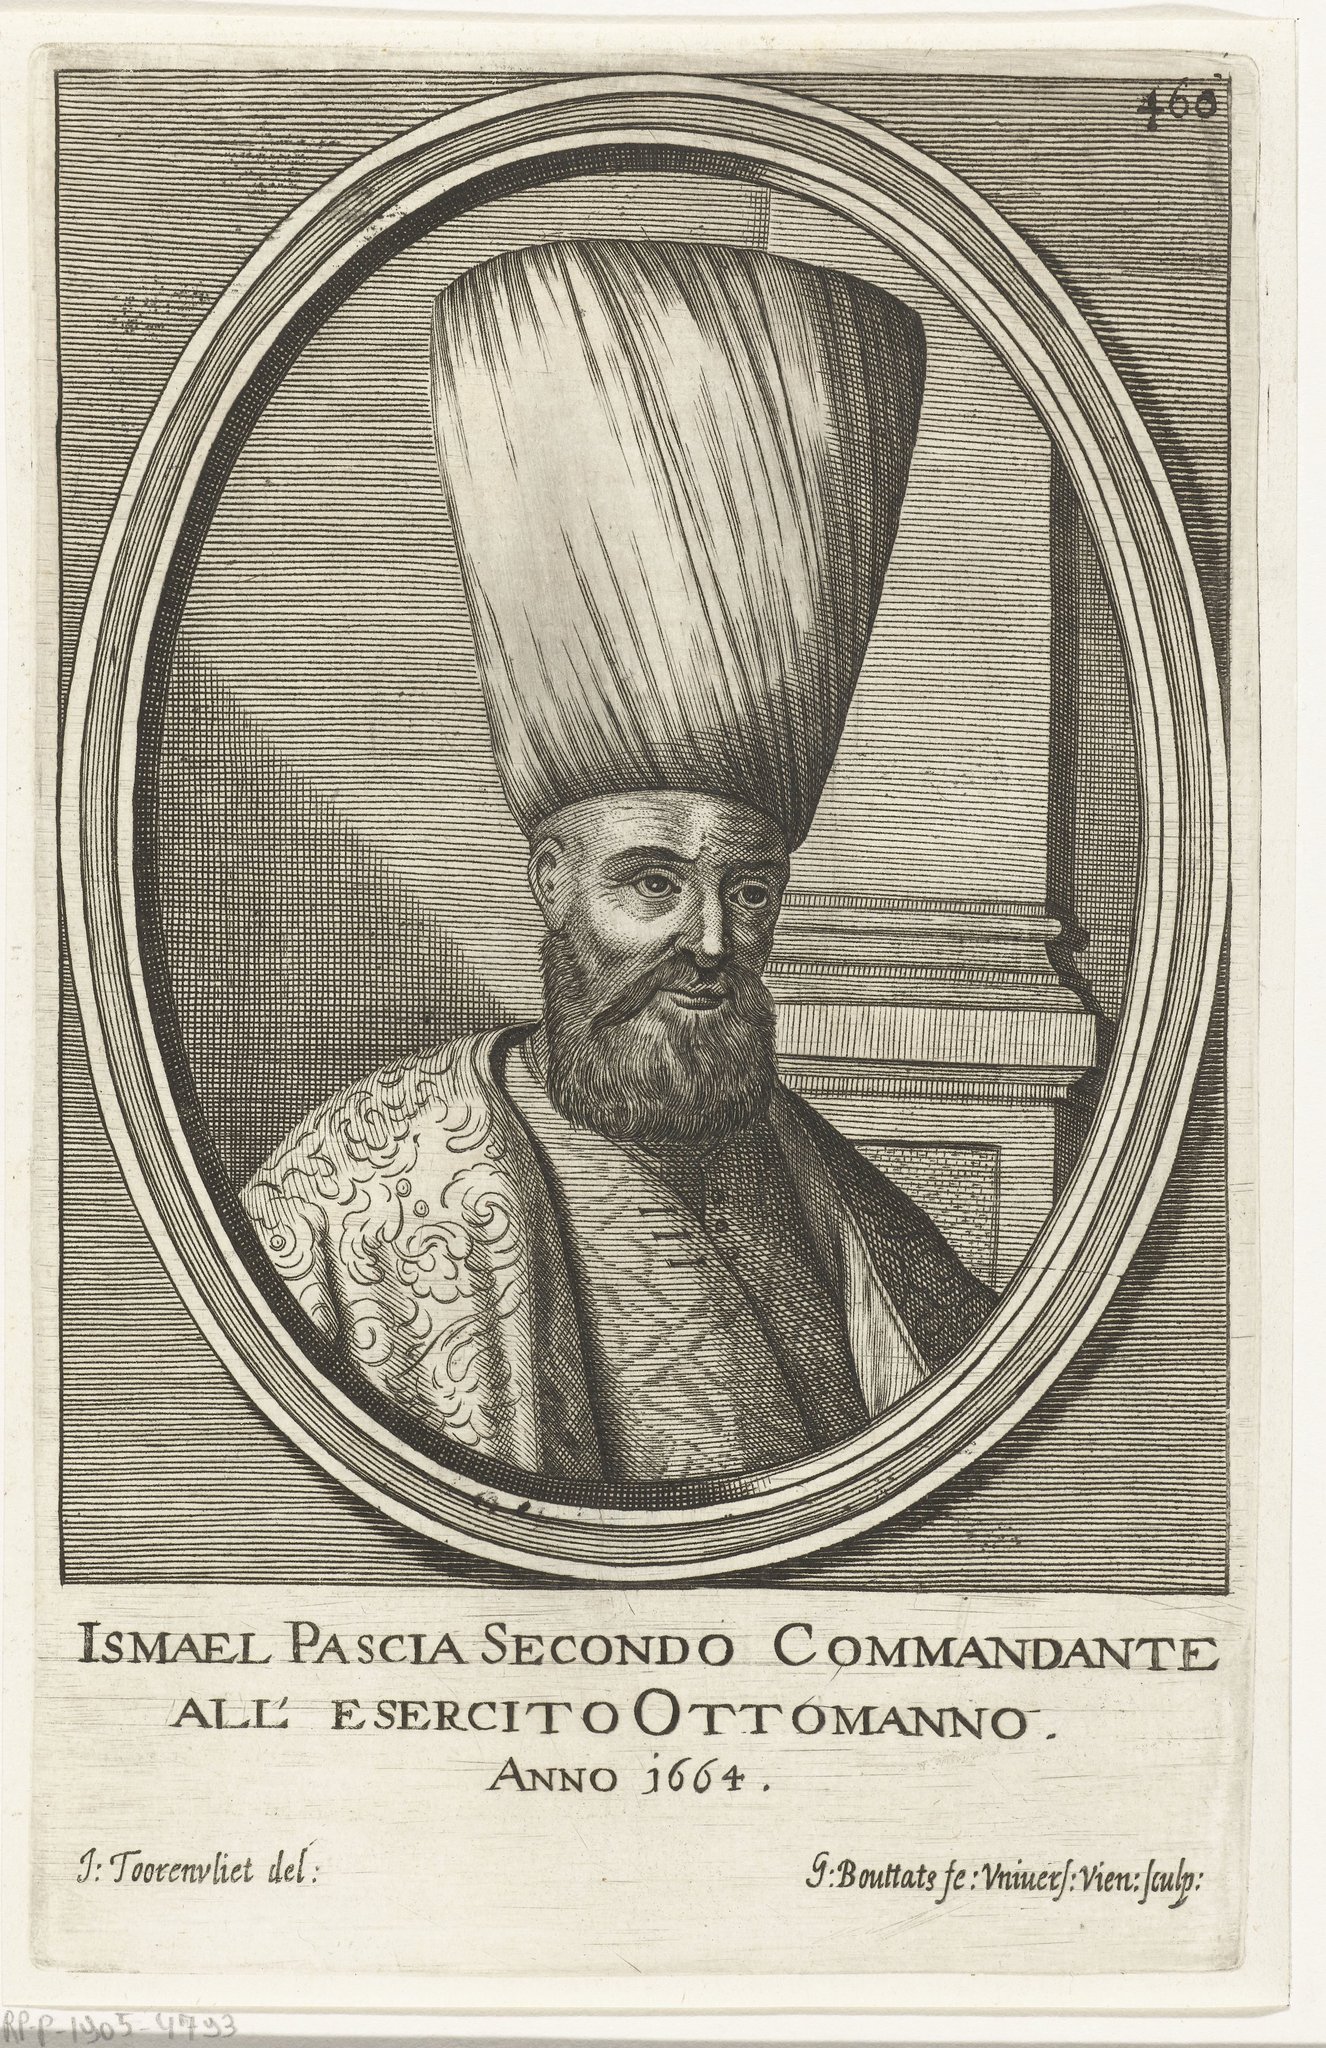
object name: print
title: Portret van Ismael Pascia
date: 1664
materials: paper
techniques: engraving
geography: vienna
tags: asiatic races and peoples: turks, head-gear: turban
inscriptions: number, collector's mark: Lugt 2228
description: Portret in een ovale lijst van Ismael Pascia, de ondercommandant van het Ottomaanse leger. Buste naar rechts. Pascia draagt een Ottomaans gewaad (kaftan) een een enorme tulband (Sarik). De prent heeft een Italiaans onderschrift met de naam van de geportretteerde.